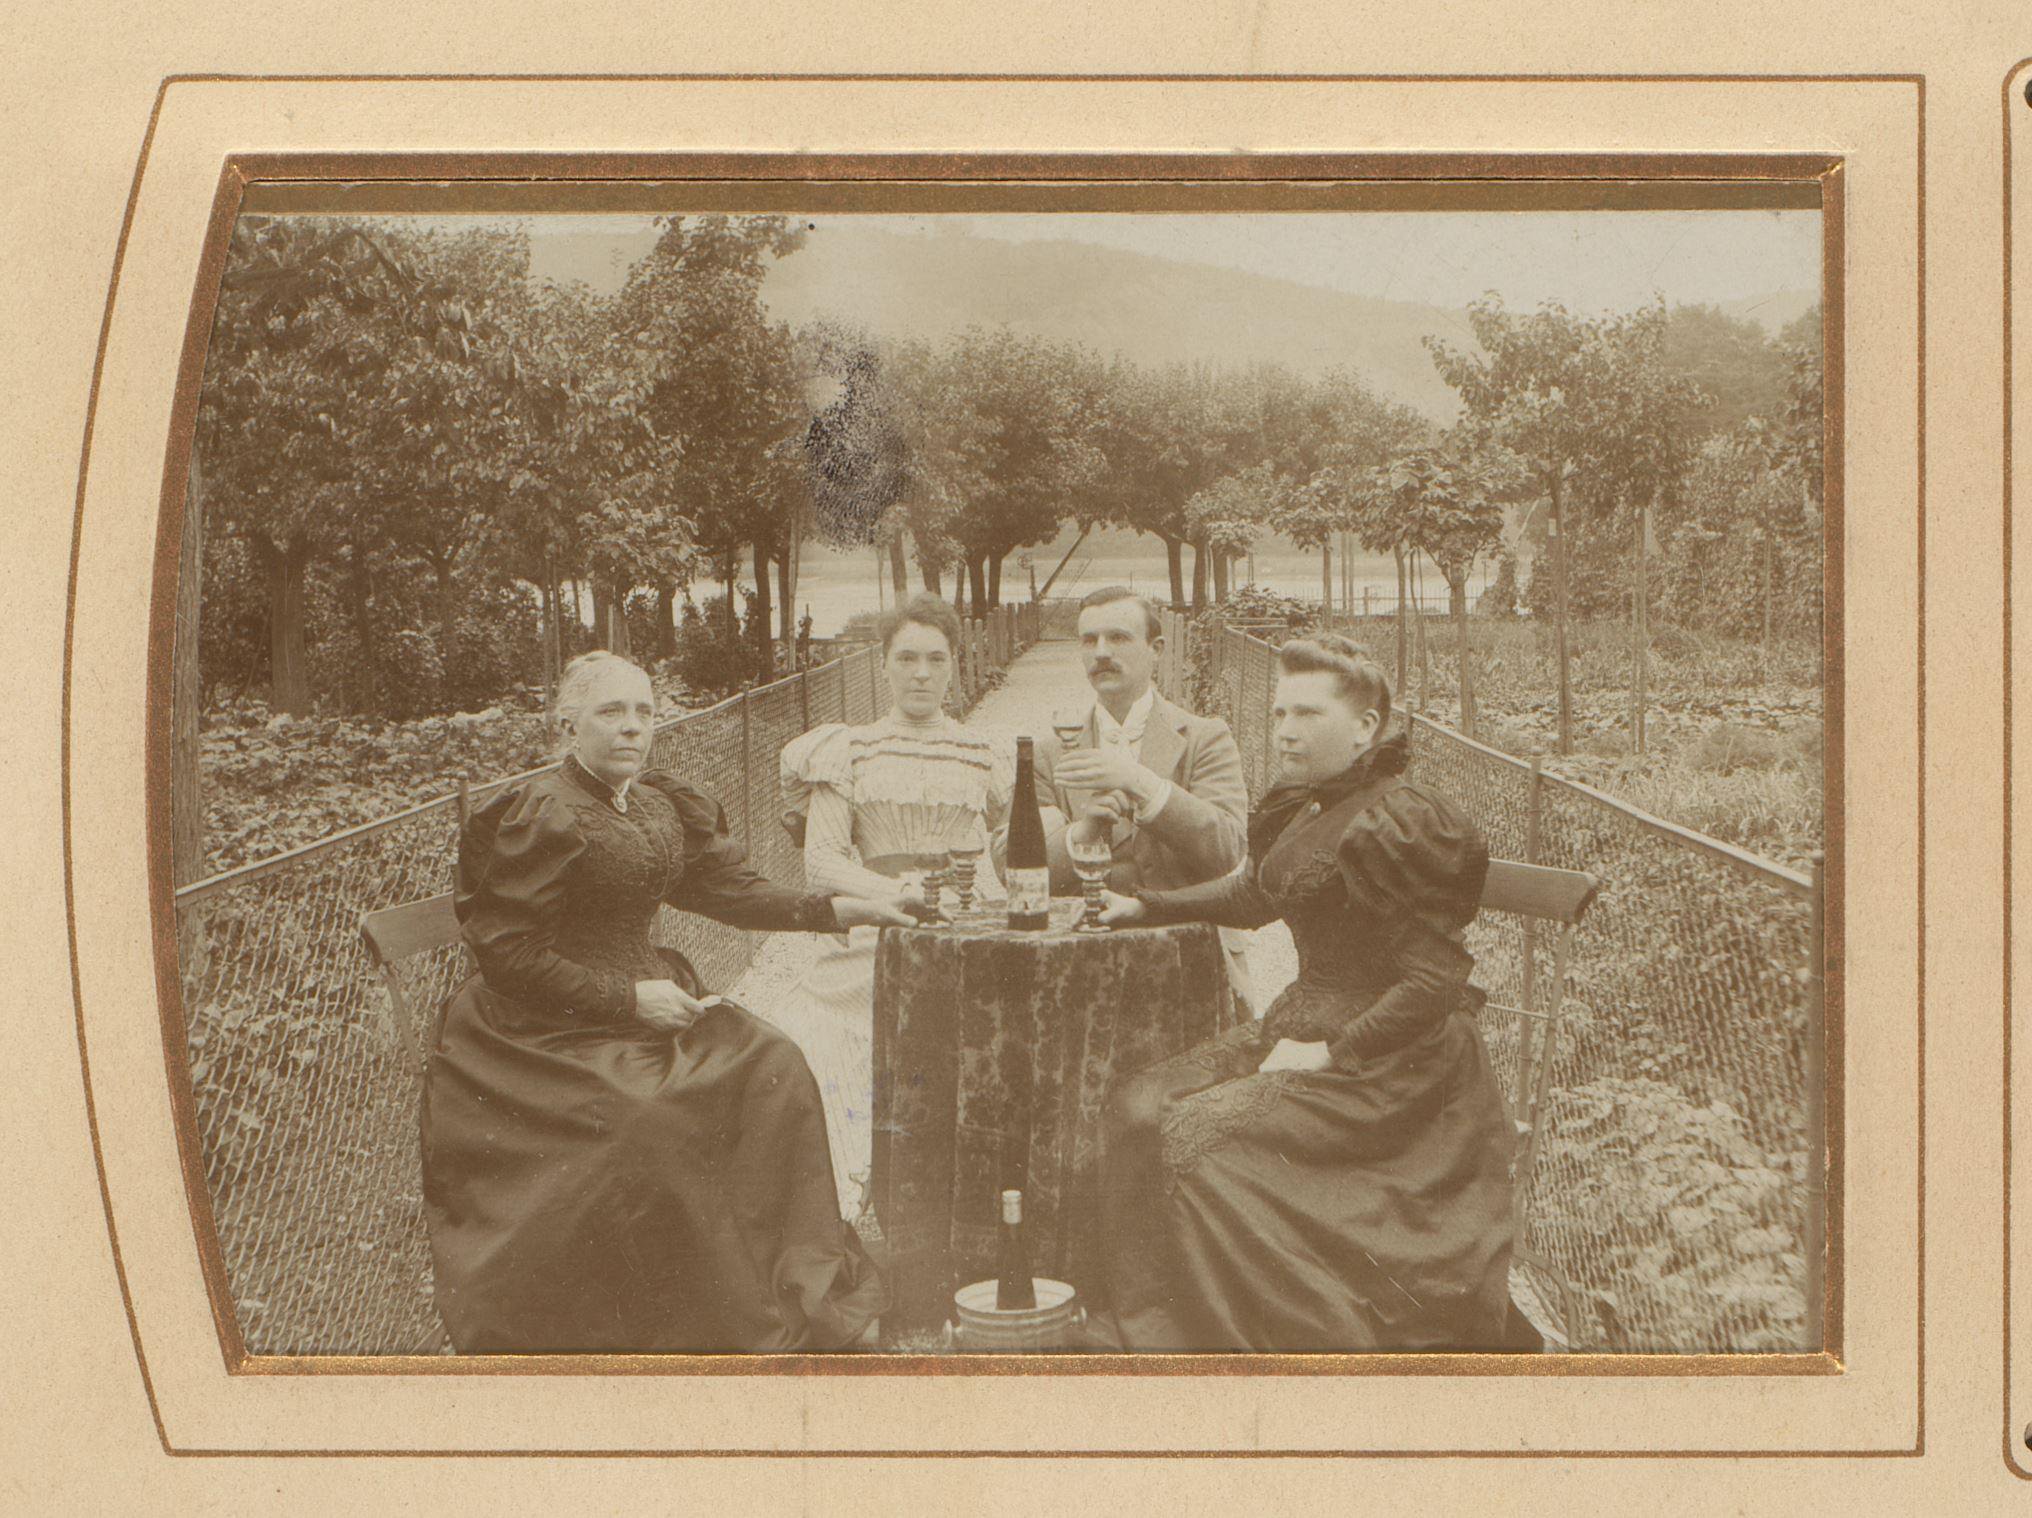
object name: cabinet photograph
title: Gezelschap, zittend in een tuin te Horchheim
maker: arthur pleimes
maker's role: fotograaf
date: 1897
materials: cardboard, photographic support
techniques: collodion silver print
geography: koblenz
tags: garden, drinking, anonymous historical persons portrayed in a group, in a group-portrait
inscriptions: inscription: ‘Atelier/ Arthur Pleimes/ Firmungstr. 8/ Coblenz’, annotation: ‘Foto in [Hollers] garten te Horchheim/ zomer 1897’, inscription: ‘[...]’